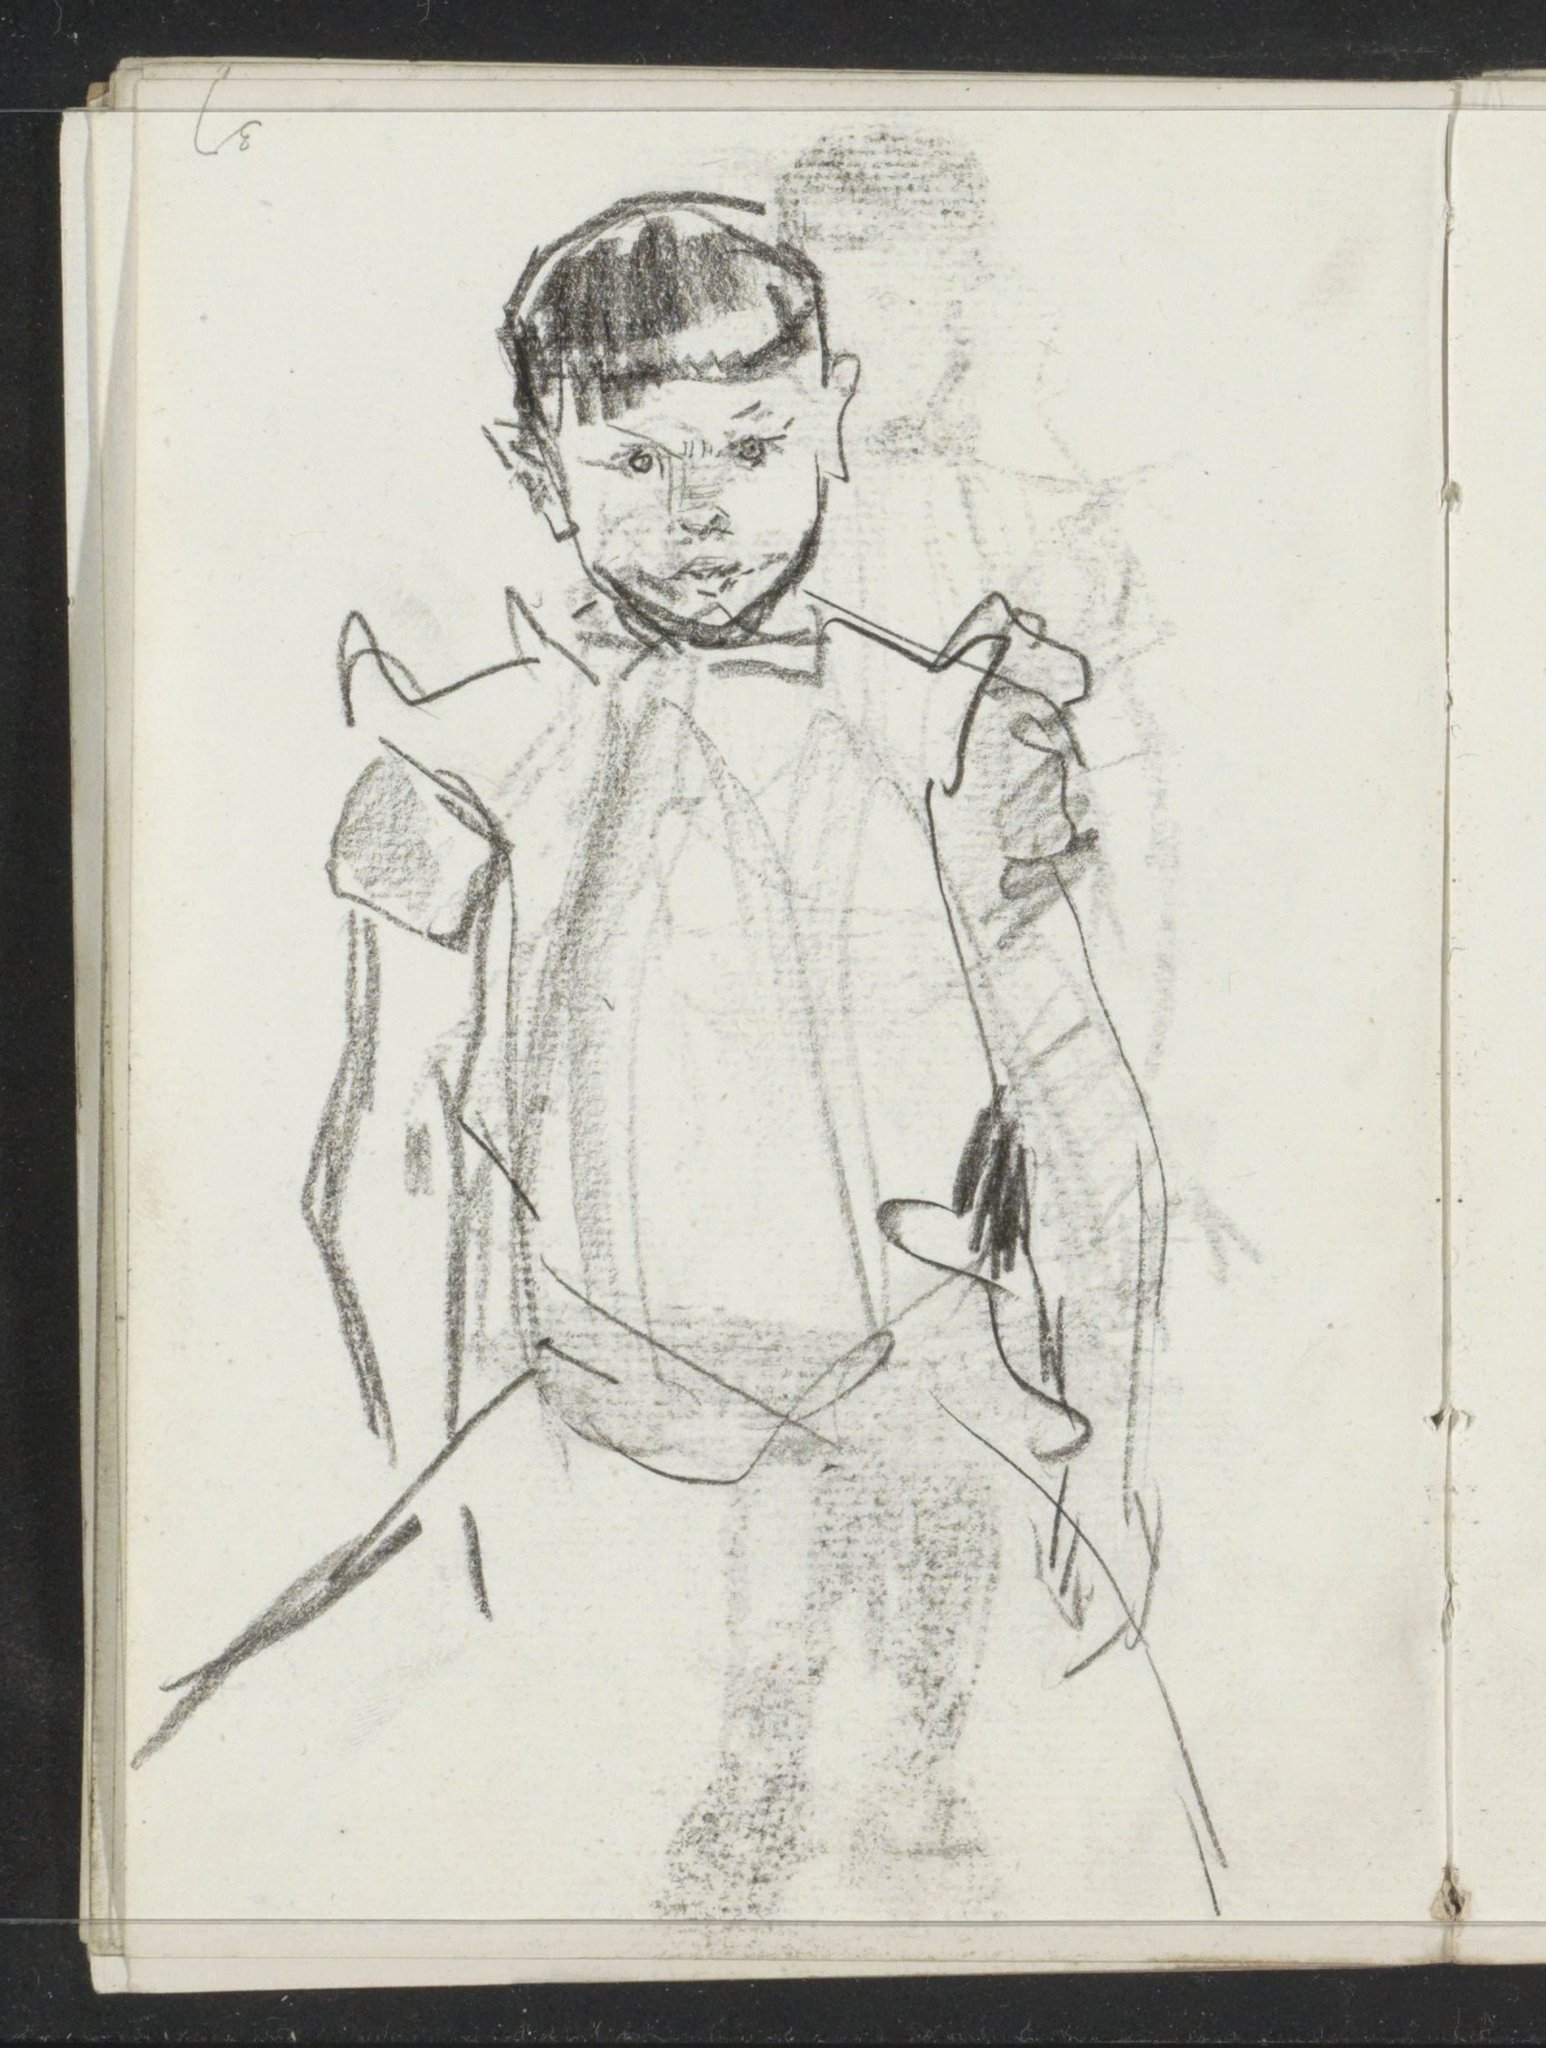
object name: sketchbook leaf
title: Meisje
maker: isaac israels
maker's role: draughtsman, painter, print maker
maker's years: 1865-1934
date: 1886-1934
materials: chalk, paper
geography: amsterdam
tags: girl (child between toddler and youth)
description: Blad 10 verso uit schetsboek LXIII met 23 bladen.